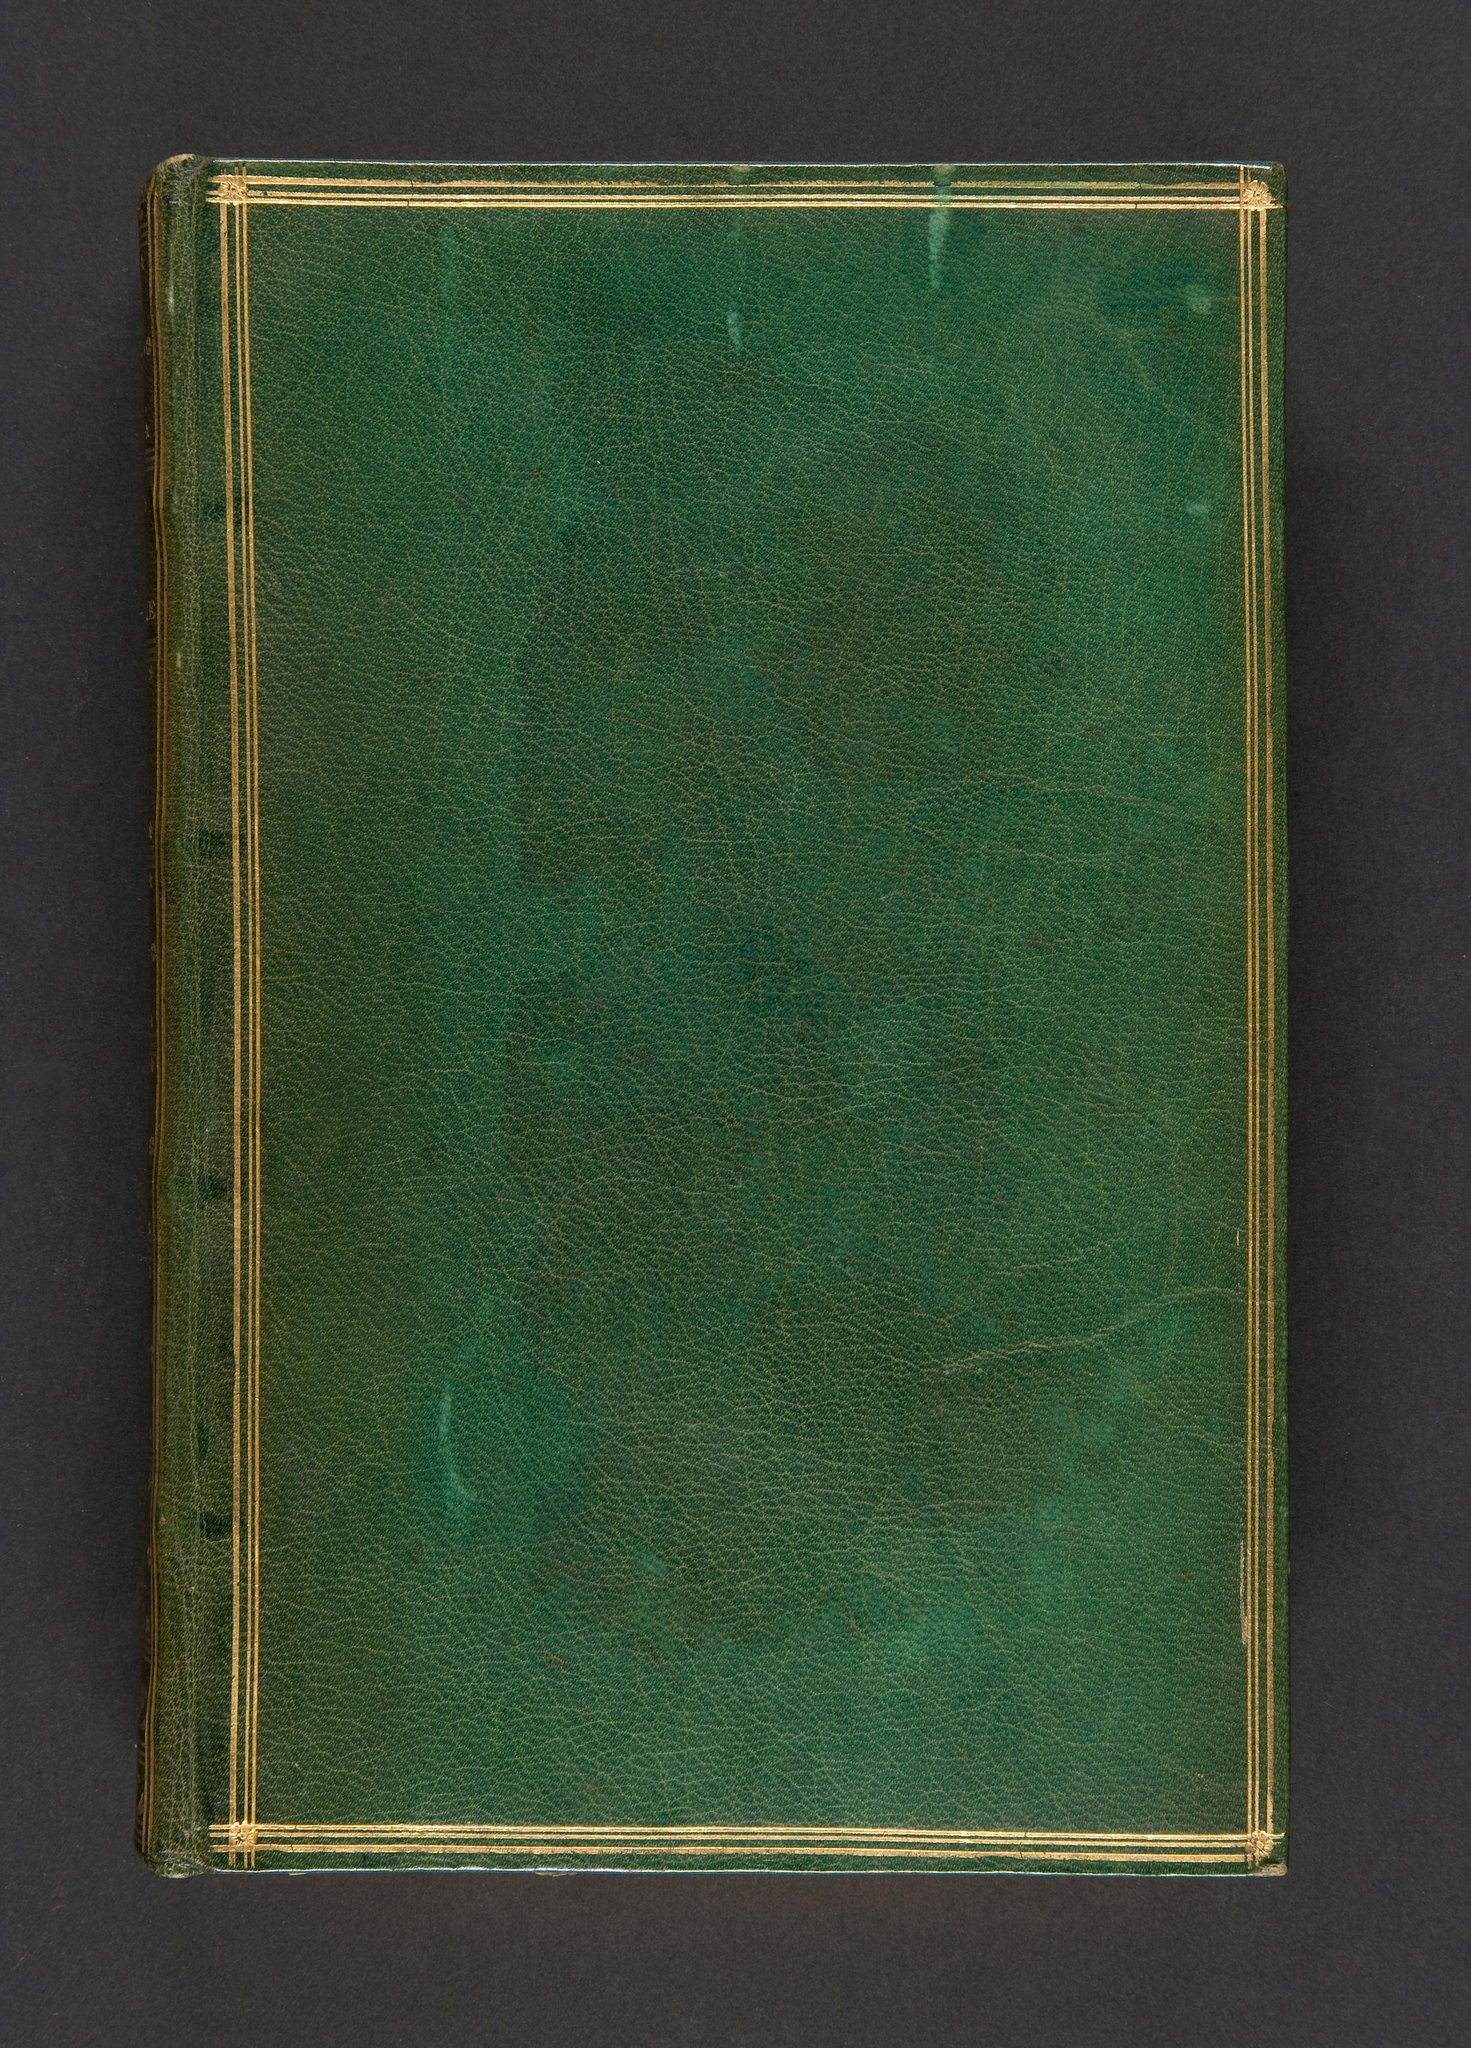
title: Oeuvres de Moliere : avec des remarques grammaticales, des avertissemens et des observations sur chaque piéce, par M. Bret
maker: jean-baptiste poquelin molière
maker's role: author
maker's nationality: french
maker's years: 1622-1673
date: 1773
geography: france